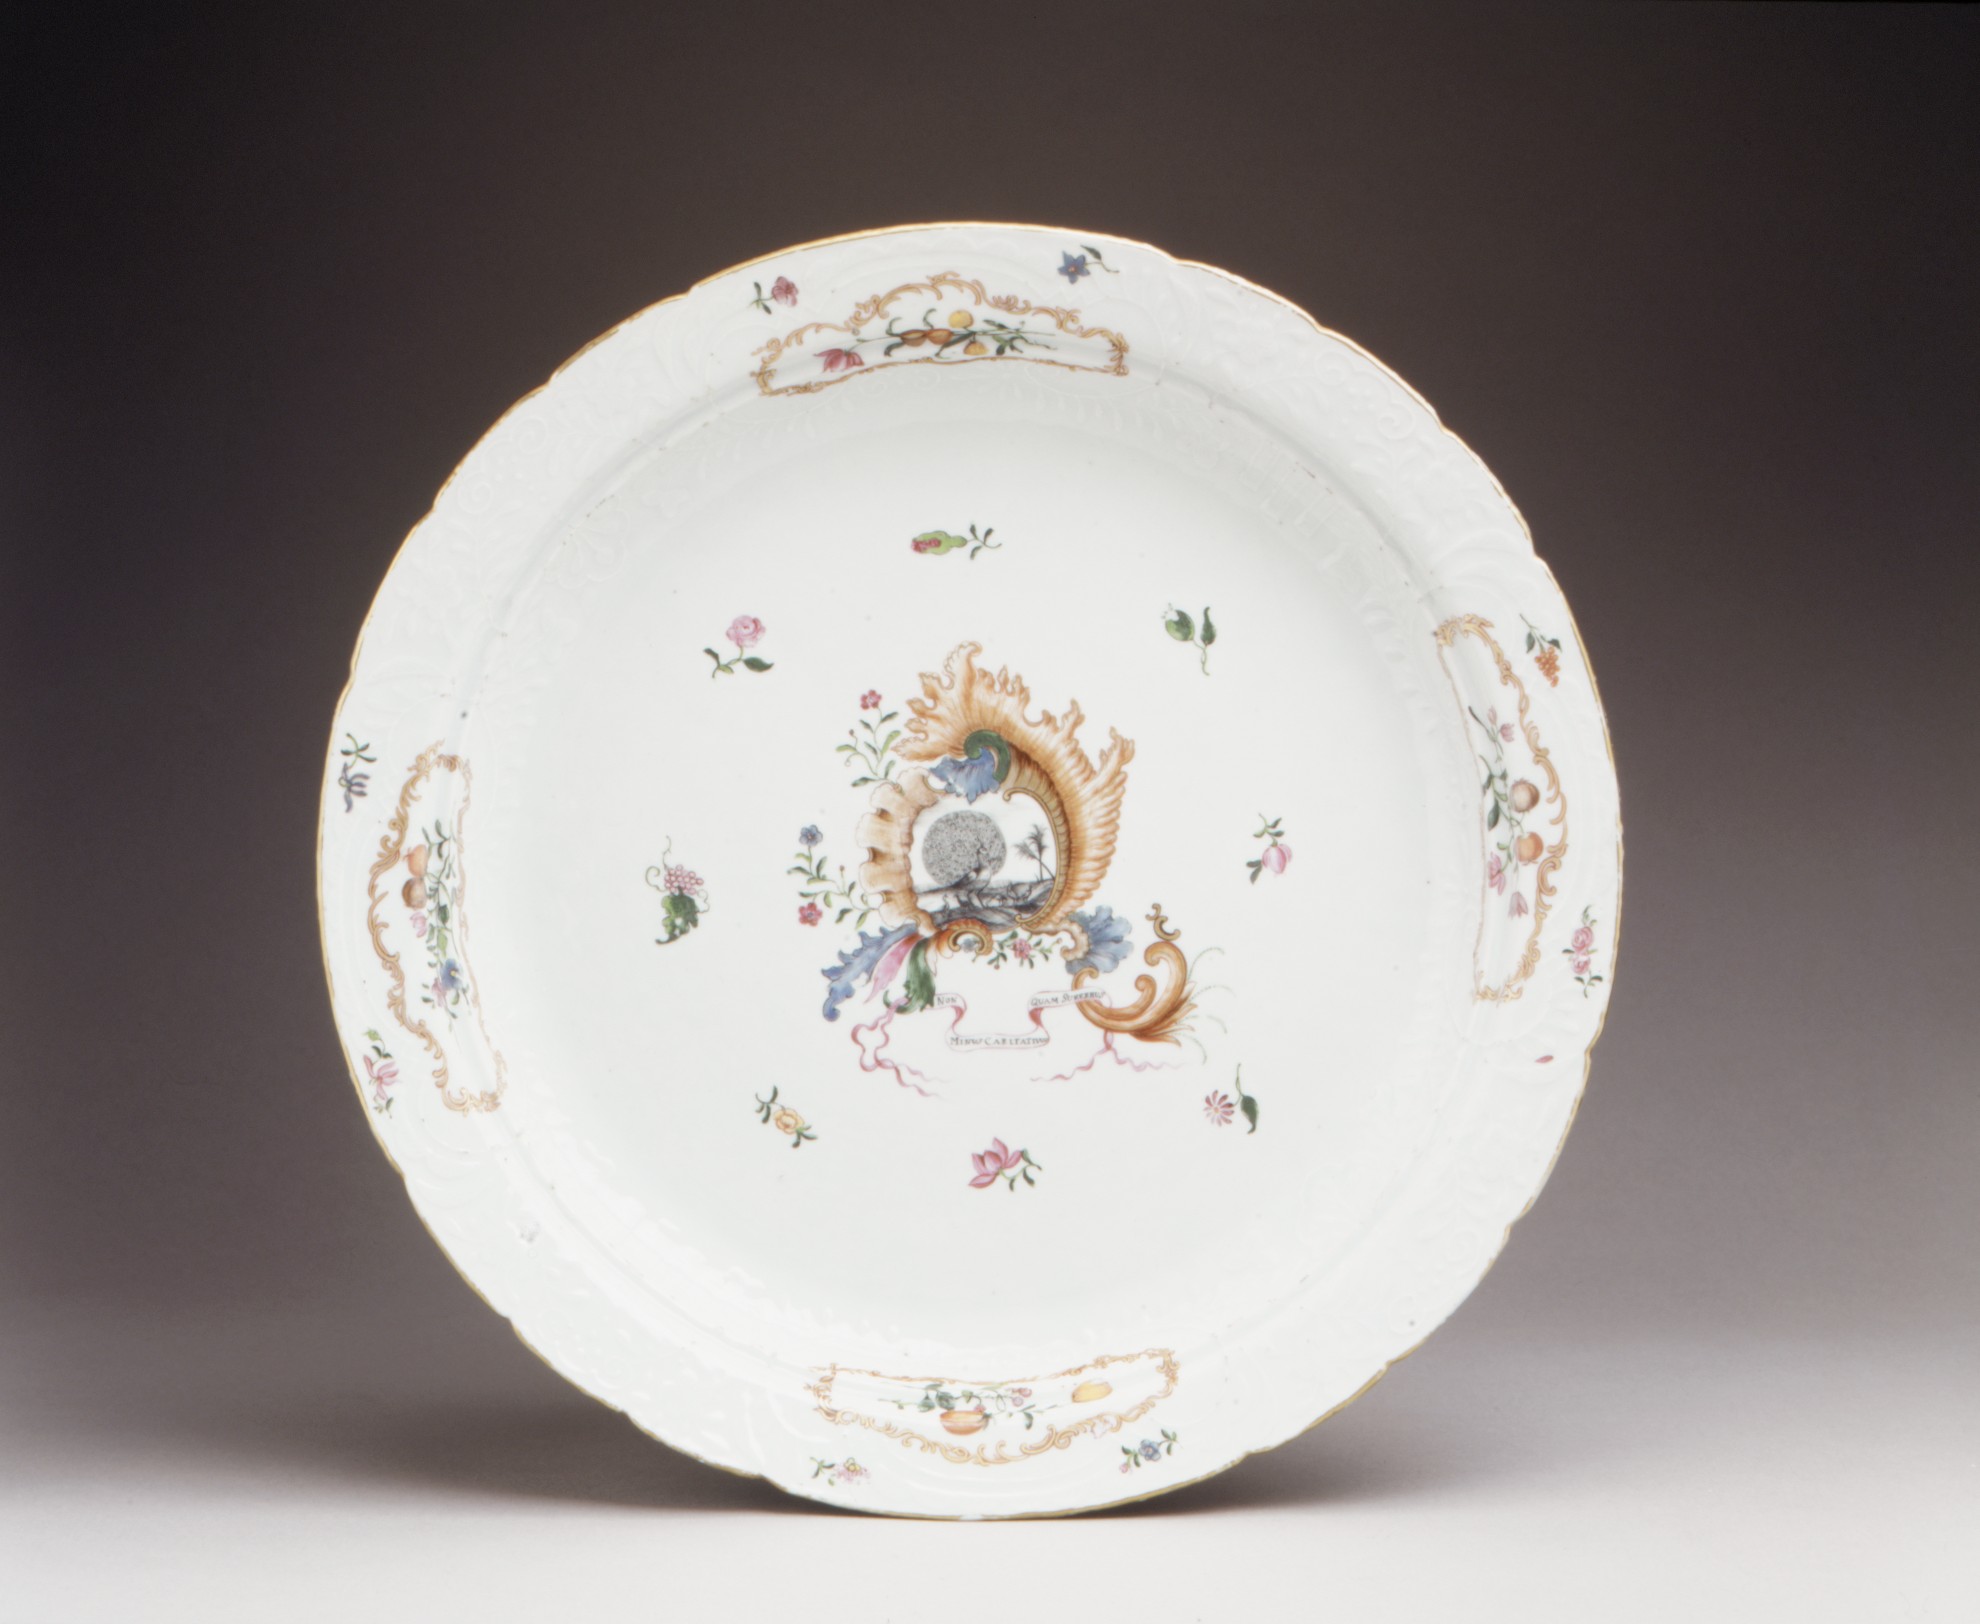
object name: dish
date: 1750-1760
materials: hard paste porcelain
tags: birds